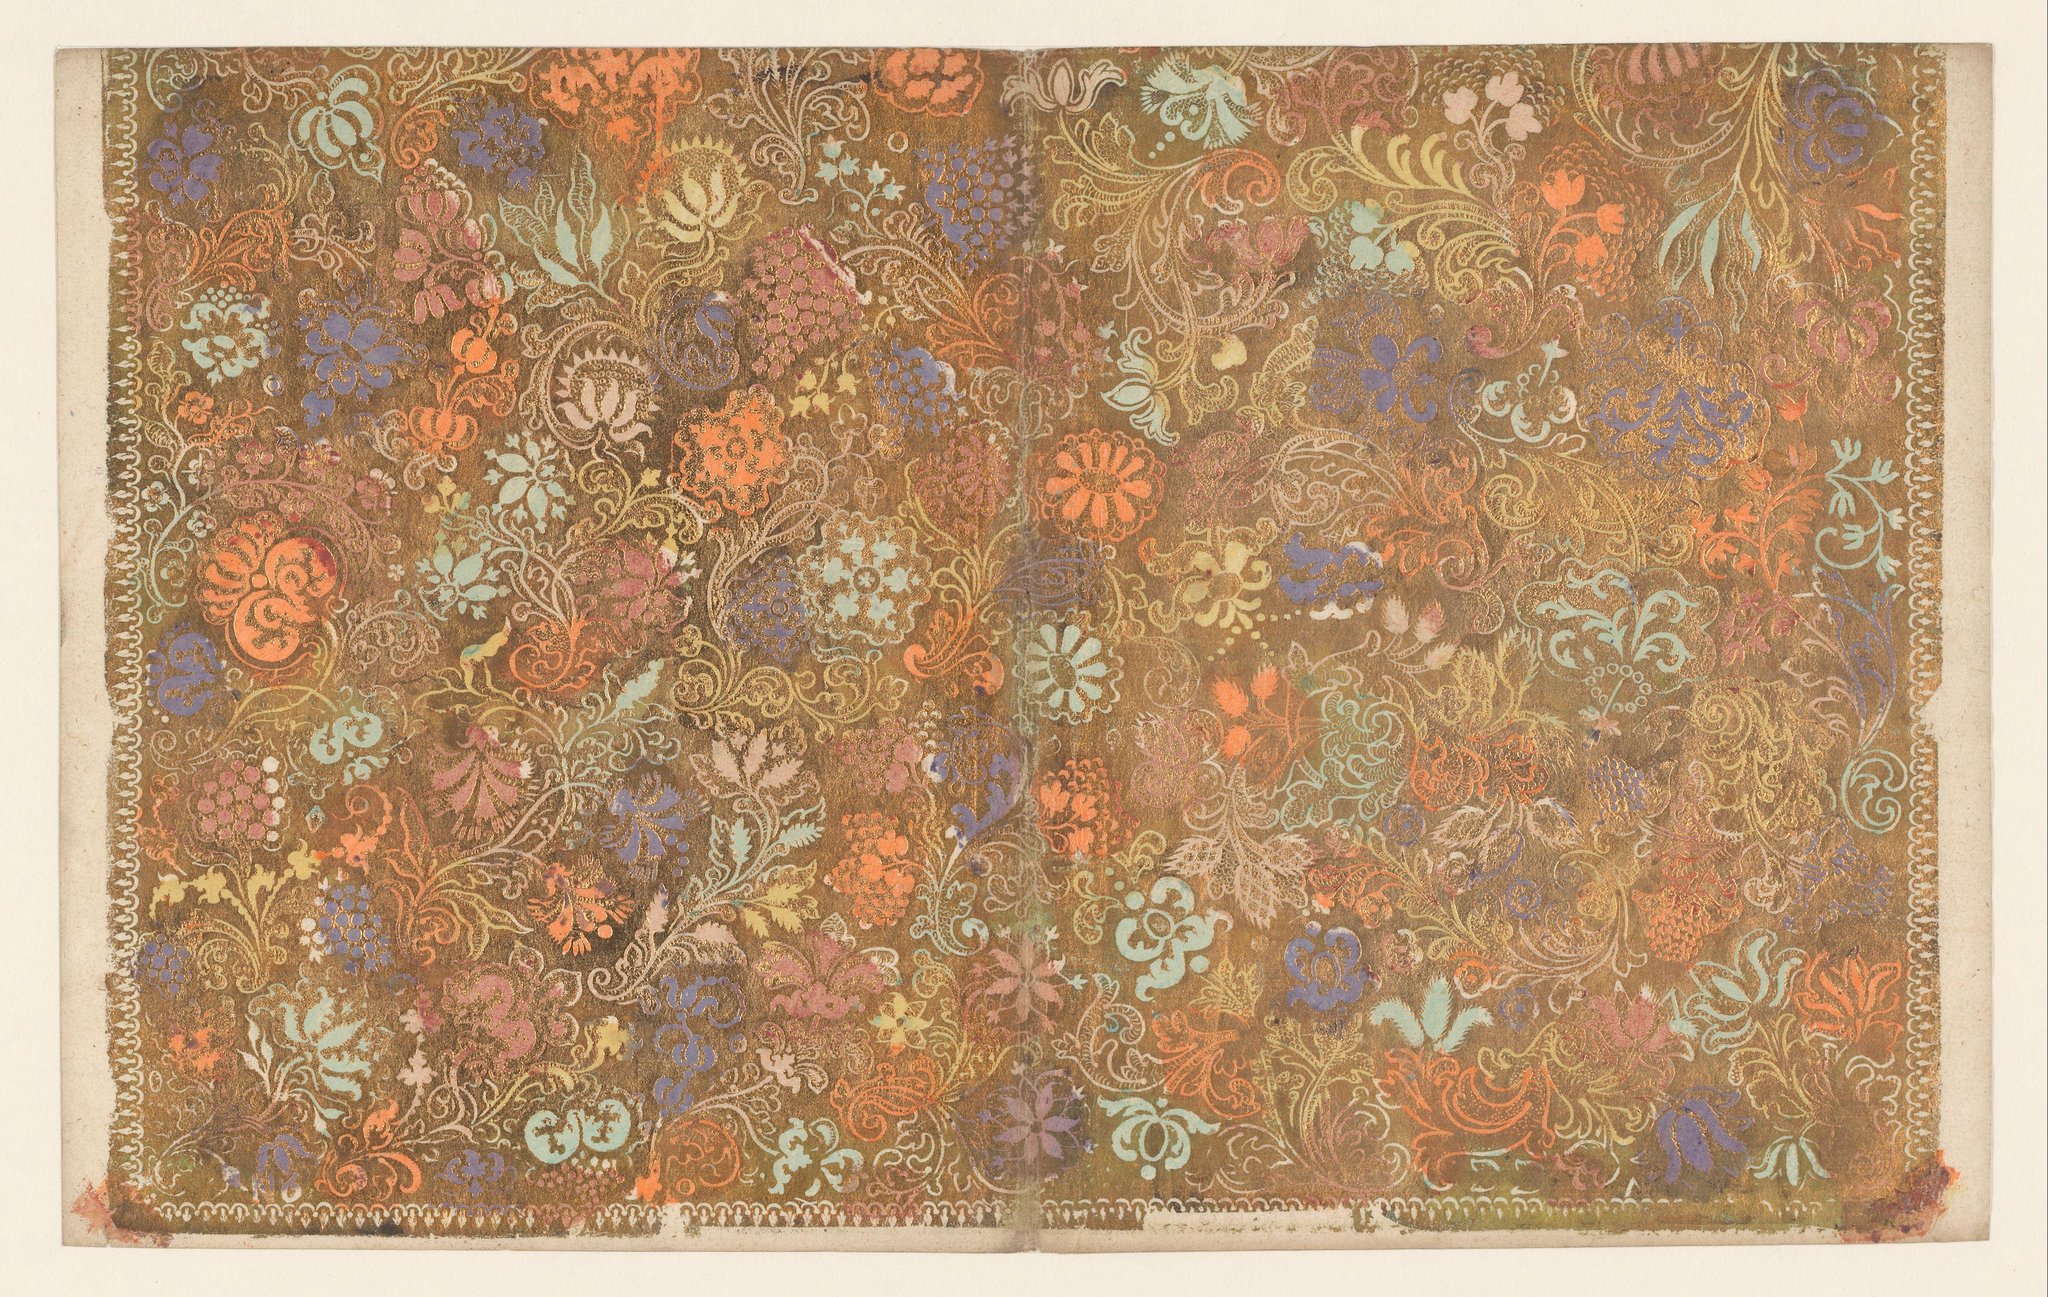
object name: brocade paper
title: Blad met strooipatroon van bloemen en vruchten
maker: Anonymous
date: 1720-1760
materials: gold leaf, paint, paper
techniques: relief print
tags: ornament derived from plant forms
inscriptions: annotation: ‘1739’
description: Blad met strooipatroon van bloemen en vruchten, met aan drie zijden witte randen en sierlijst. Gebruikt als omslag voor een publikatie uit 1739.